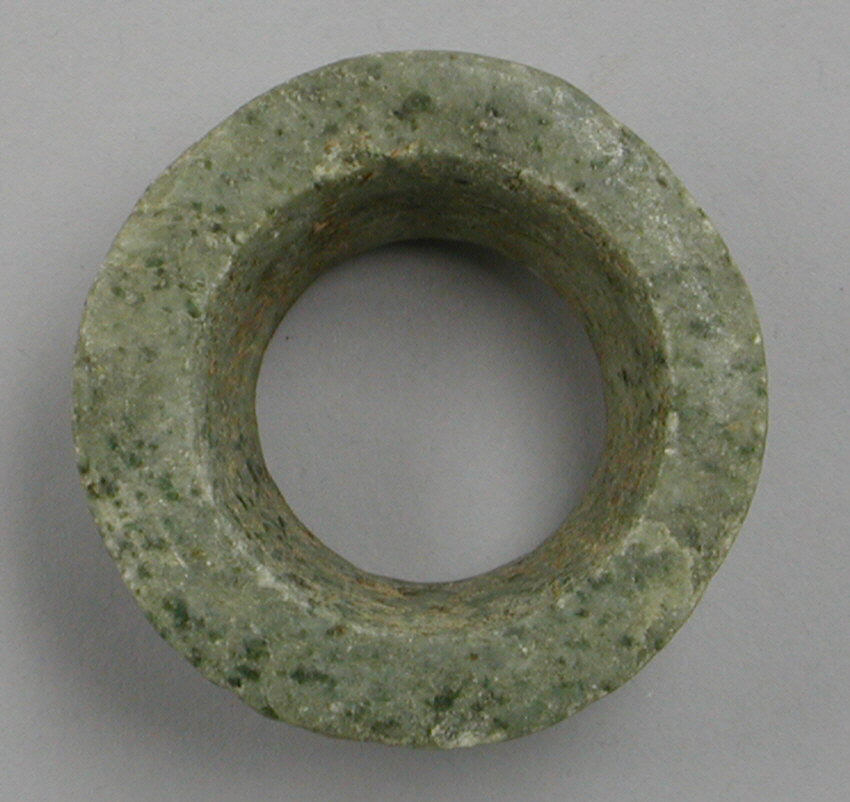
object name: earflare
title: Stone Earflare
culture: mexican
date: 1501-1600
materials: stone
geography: mexico